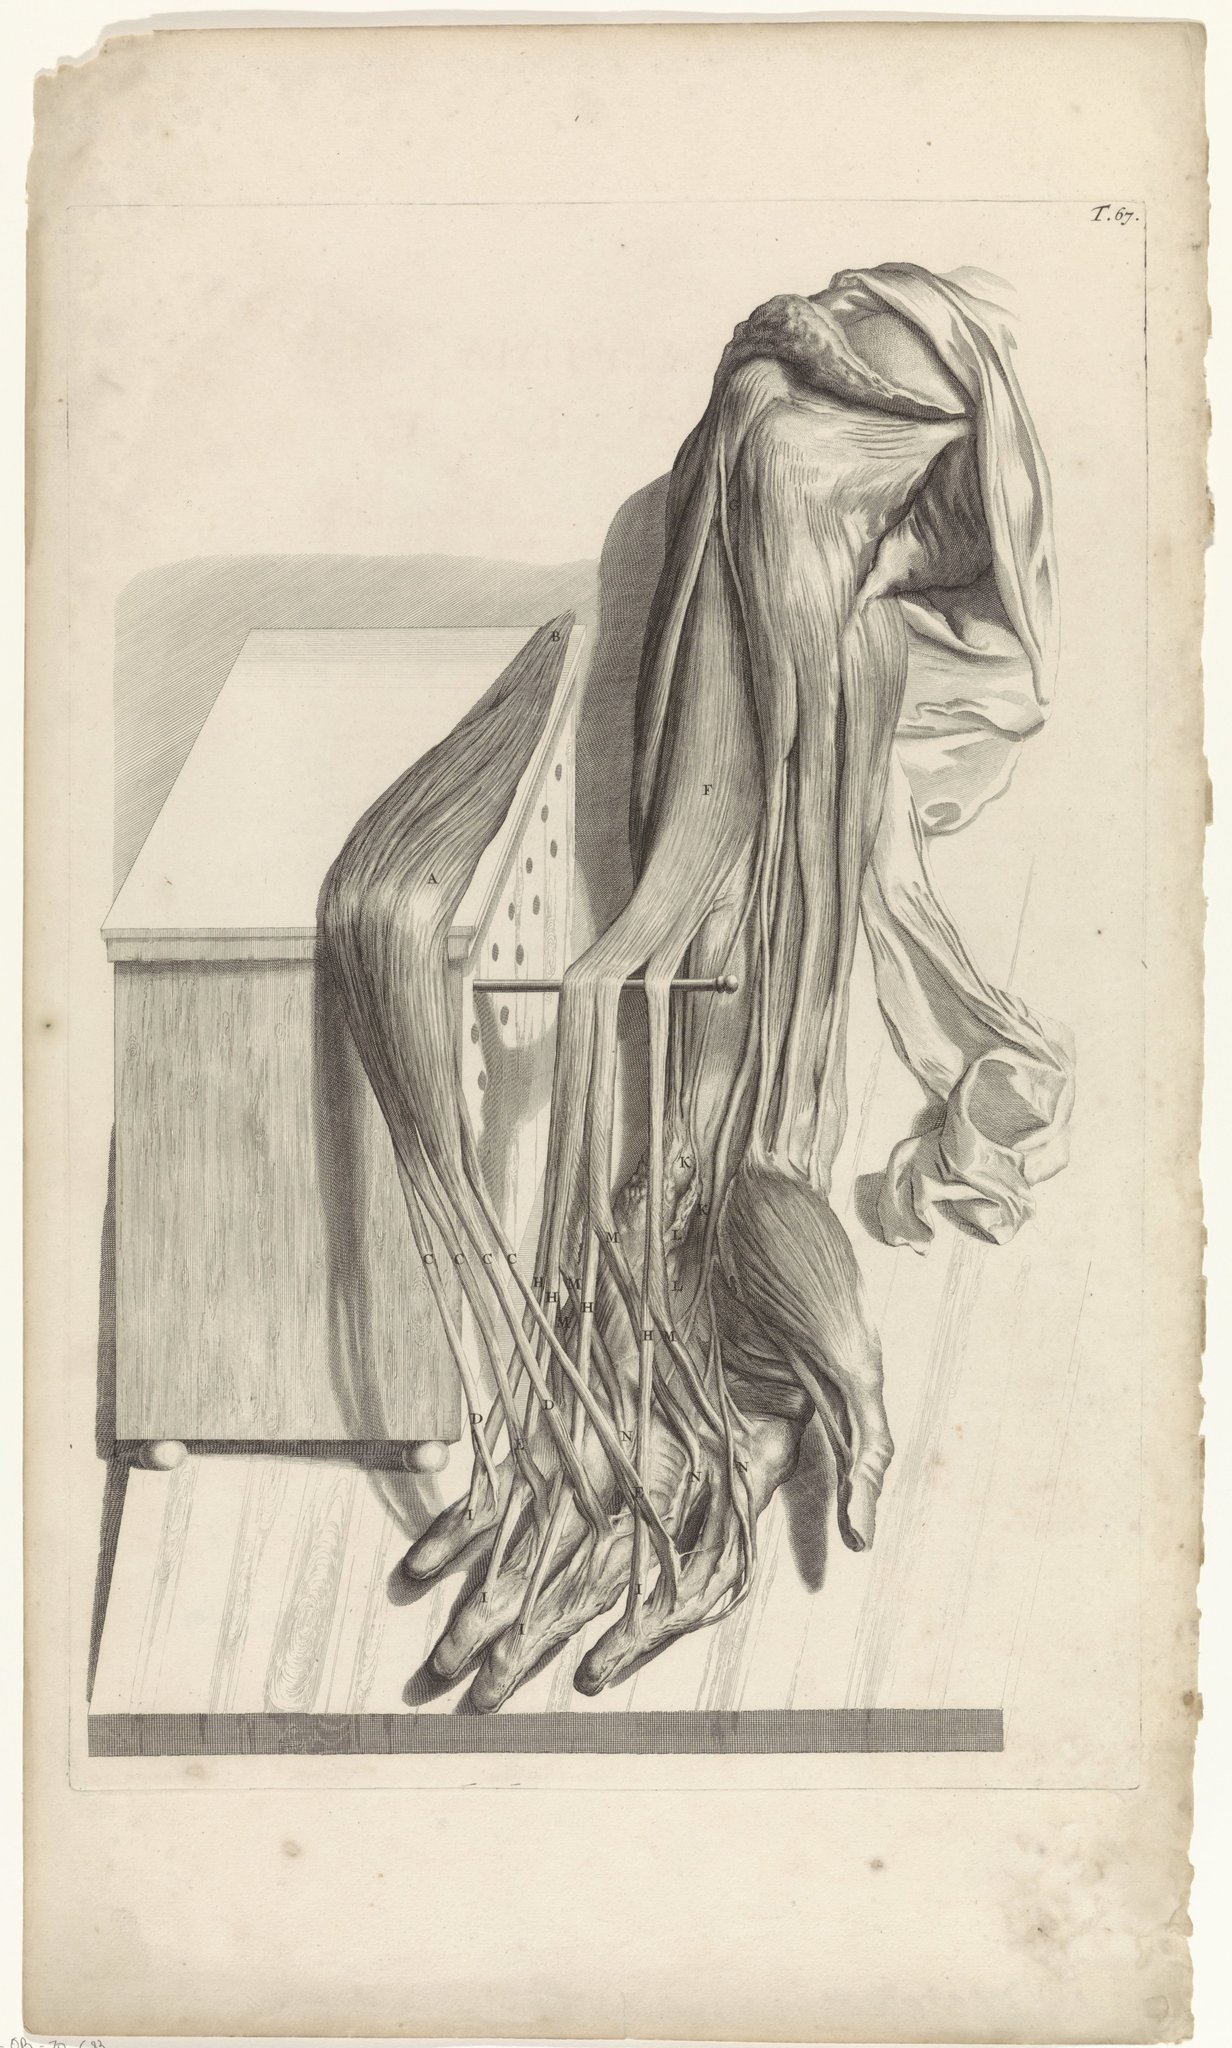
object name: print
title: Anatomische studie van de spieren van de linkeronderarm en de hand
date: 1685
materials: paper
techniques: engraving, etching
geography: amsterdam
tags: lower arm, hand, muscles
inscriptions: collector's mark: Lugt 2228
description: Boekillustratie voor Bidloo, Godefridus. Anatomia humani corporis centum & quinque tabulis, per art. G. de Lairesse ad vivum delineatis, de monstrata, veterum recentiorumque inventis explicata plurimisque, hactenus non detectis, illustrata. Amsterdam: Weduwe Joannes van Someren, Hendrick Boom en erven Dirk Boom, 1685.